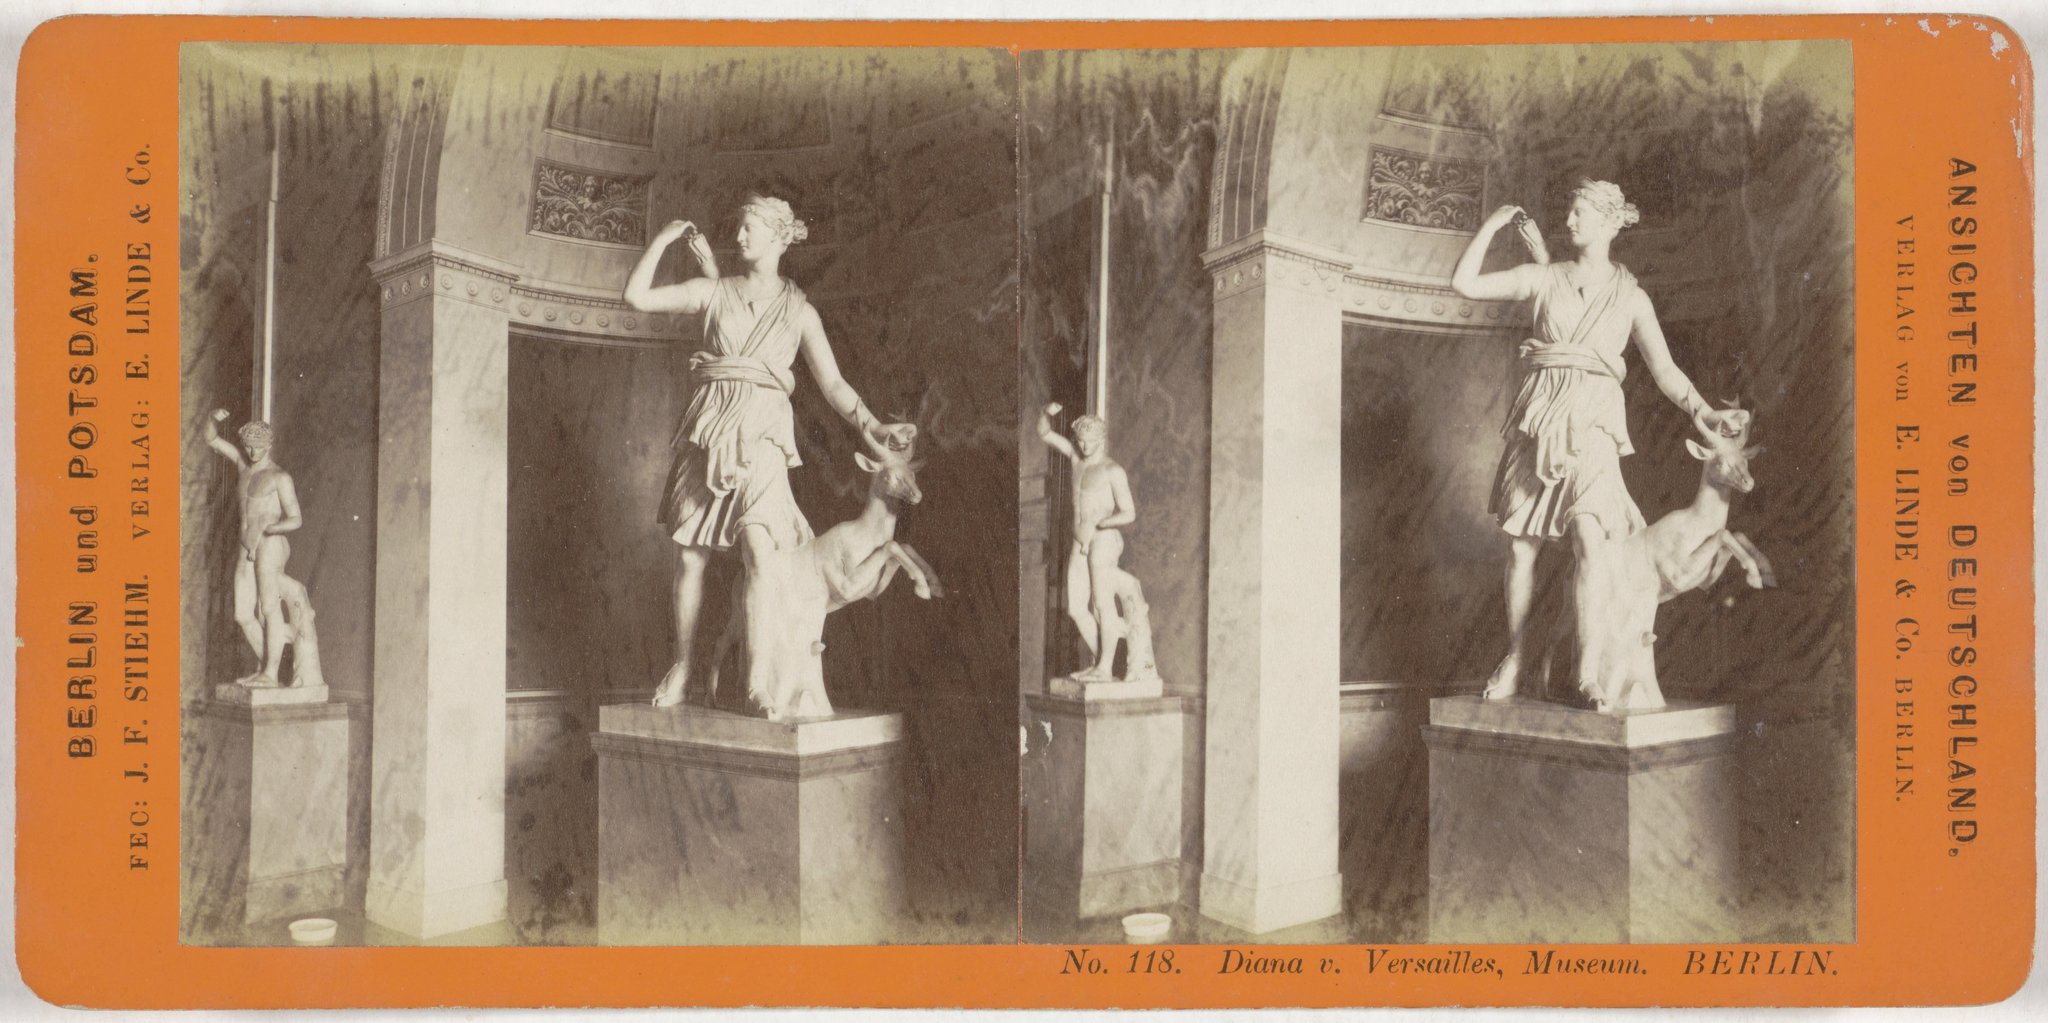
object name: stereograph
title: Ansichten von Deutschland / Berlin und Potsdam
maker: johann friedrich stiehm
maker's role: fotograaf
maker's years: 1826-1902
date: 1868-1870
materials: cardboard, paper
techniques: albumen print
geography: berlin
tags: diana hunting, permanent exhibition, museum, sculpture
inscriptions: number: ‘No. 118’